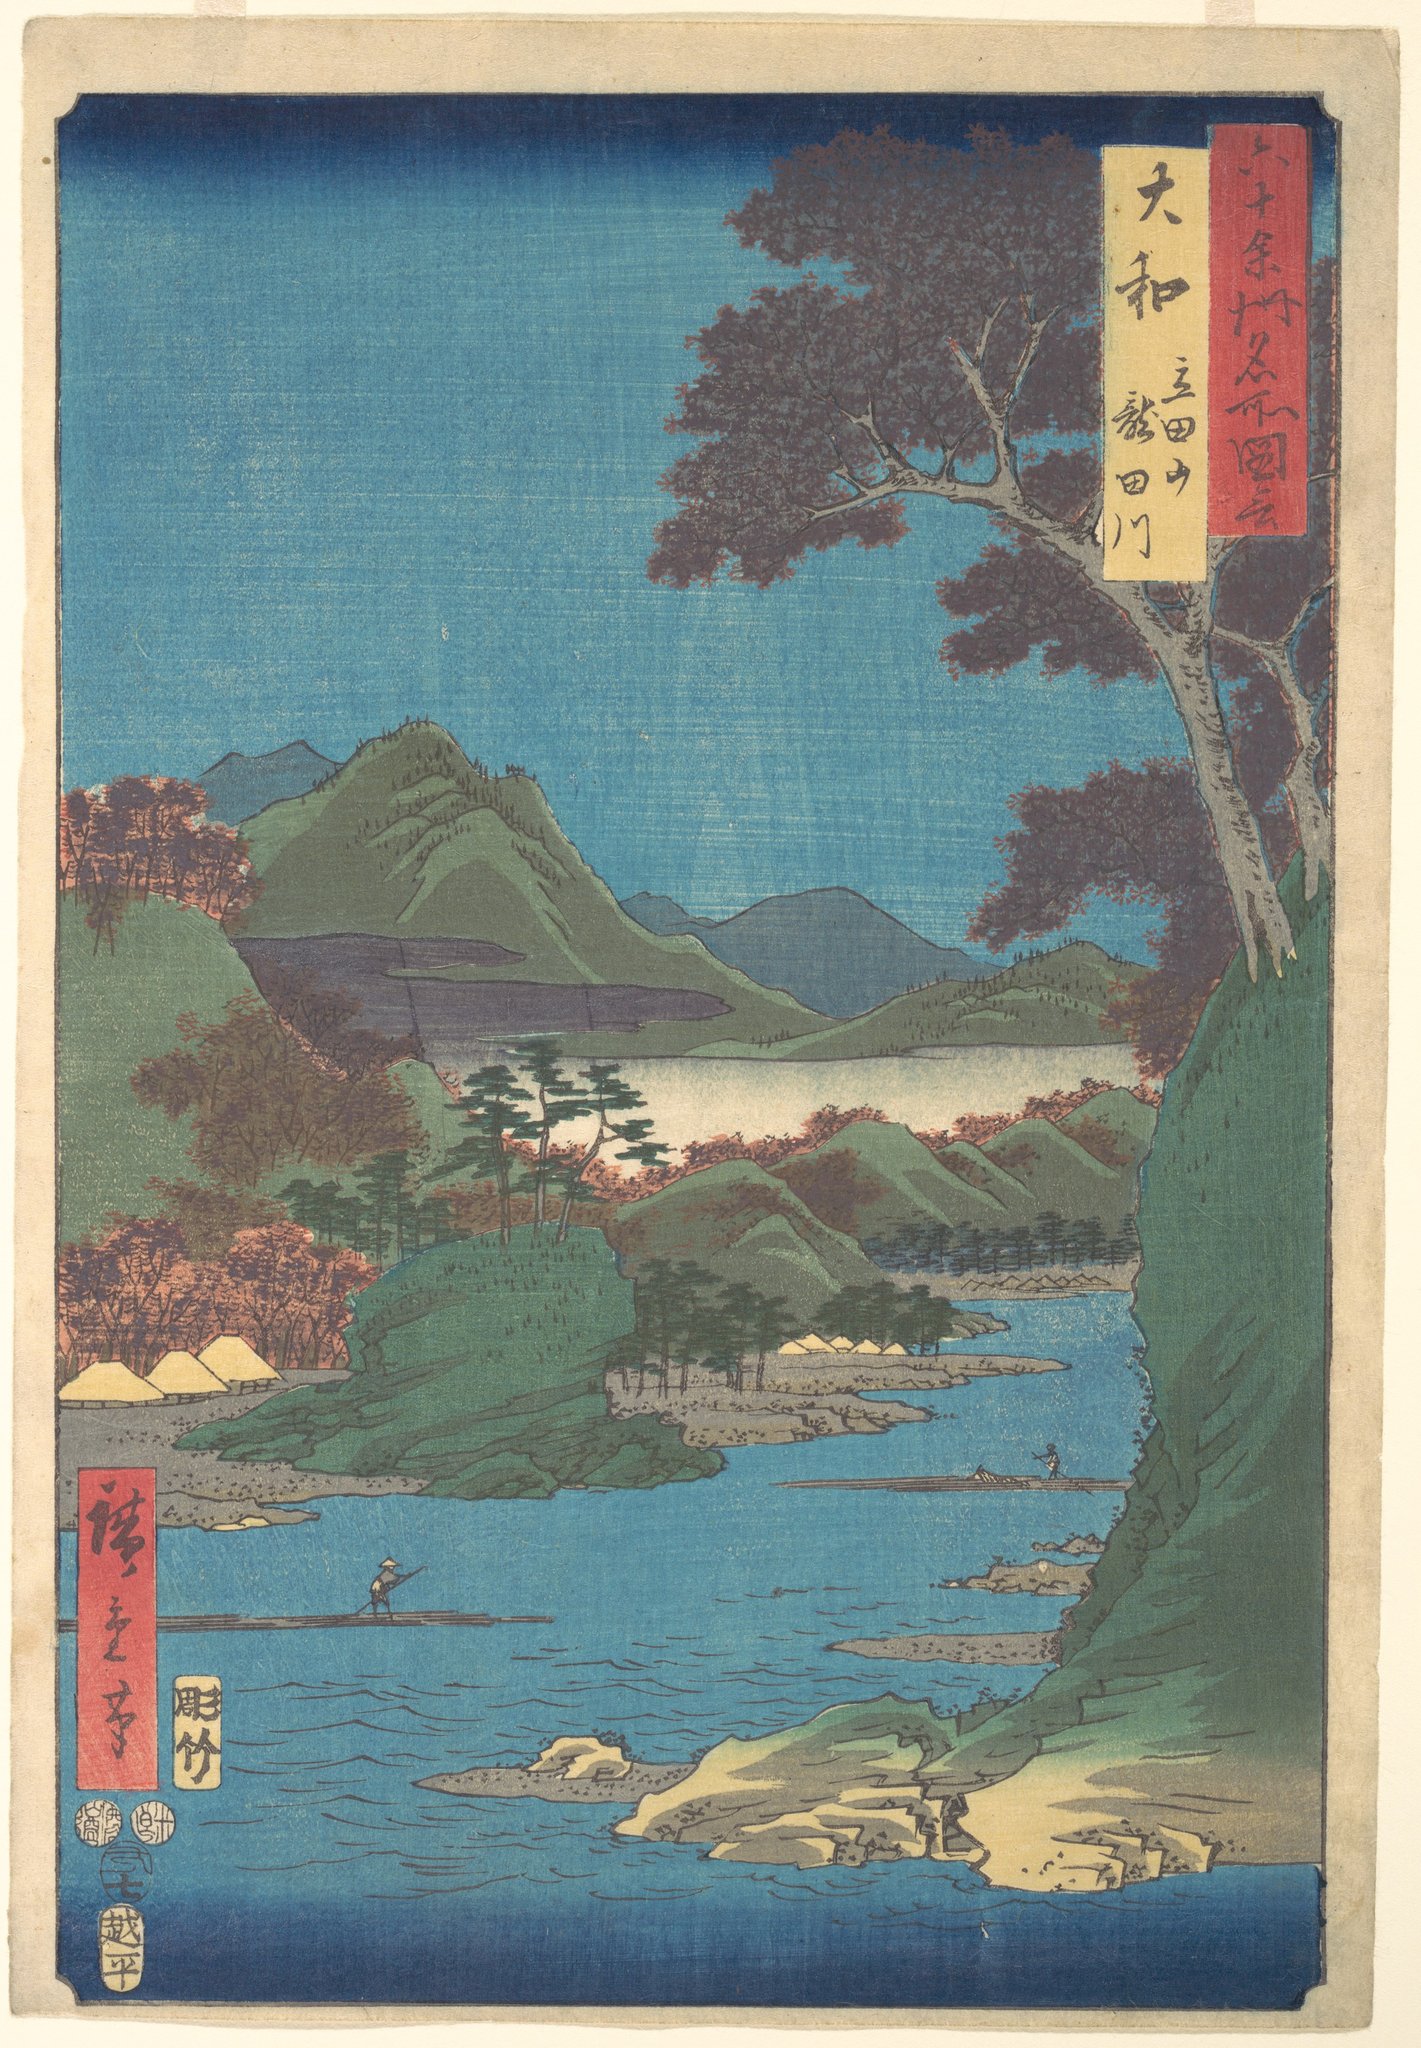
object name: print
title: Yamato, Tatsutayama, Tatsutagawa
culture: japanese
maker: utagawa hiroshige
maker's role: artist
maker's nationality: japanese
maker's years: 1797-1858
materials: ink, paper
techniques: woodblock print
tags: hills,landscapes